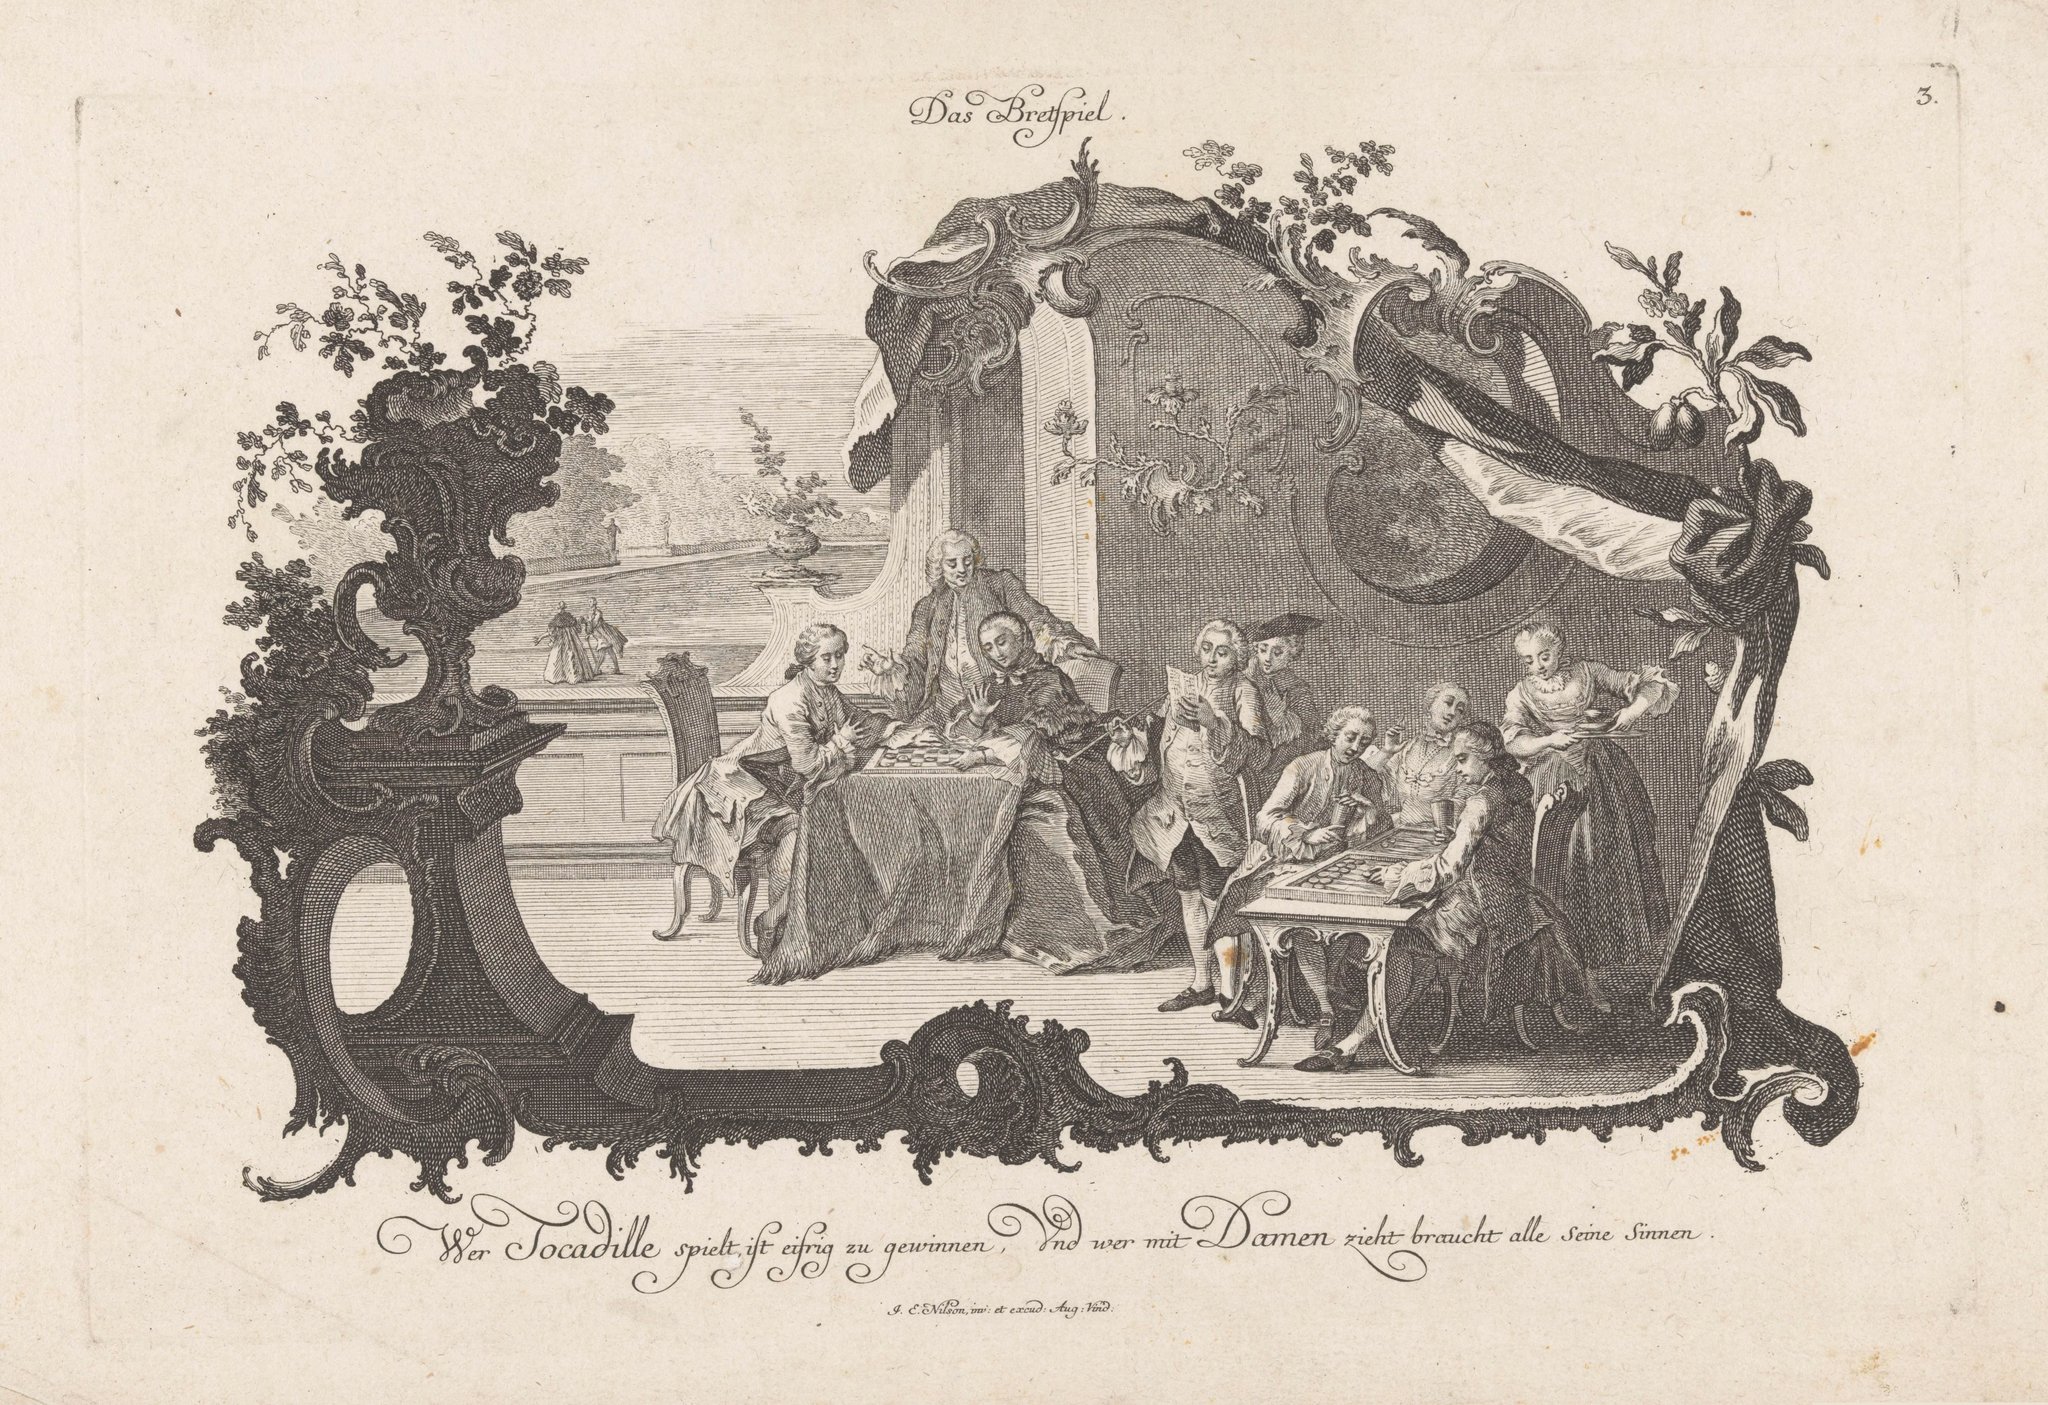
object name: ornament print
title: Bordspel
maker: johann esaias nilson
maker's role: draughtsman, print maker, publisher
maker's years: 1721-1788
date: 1731-1788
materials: paper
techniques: engraving, etching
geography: augsburg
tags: draughts, backgammon, tric-trac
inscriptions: collector's mark: Lugt 2760, collector's mark: Lugt 2228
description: Links zitten een man en een vrouw aan tafel te dammen, een man voegt zich bij hen aan tafel. Rechts zitten twee mannen en een vrouw aan tafel, de twee mannen spelen tokadille. Tussen de twee tafels staan twee mannen, de voorste leest al rokend een brief. Rechts staat een vrouw met servies. Achter hen een rocaille ornament met doorkijk naar een park. Op de voorgrond een rocaille omlijsting met een vaas en bloemmotieven. In de ondermarge een Duitse tekst.